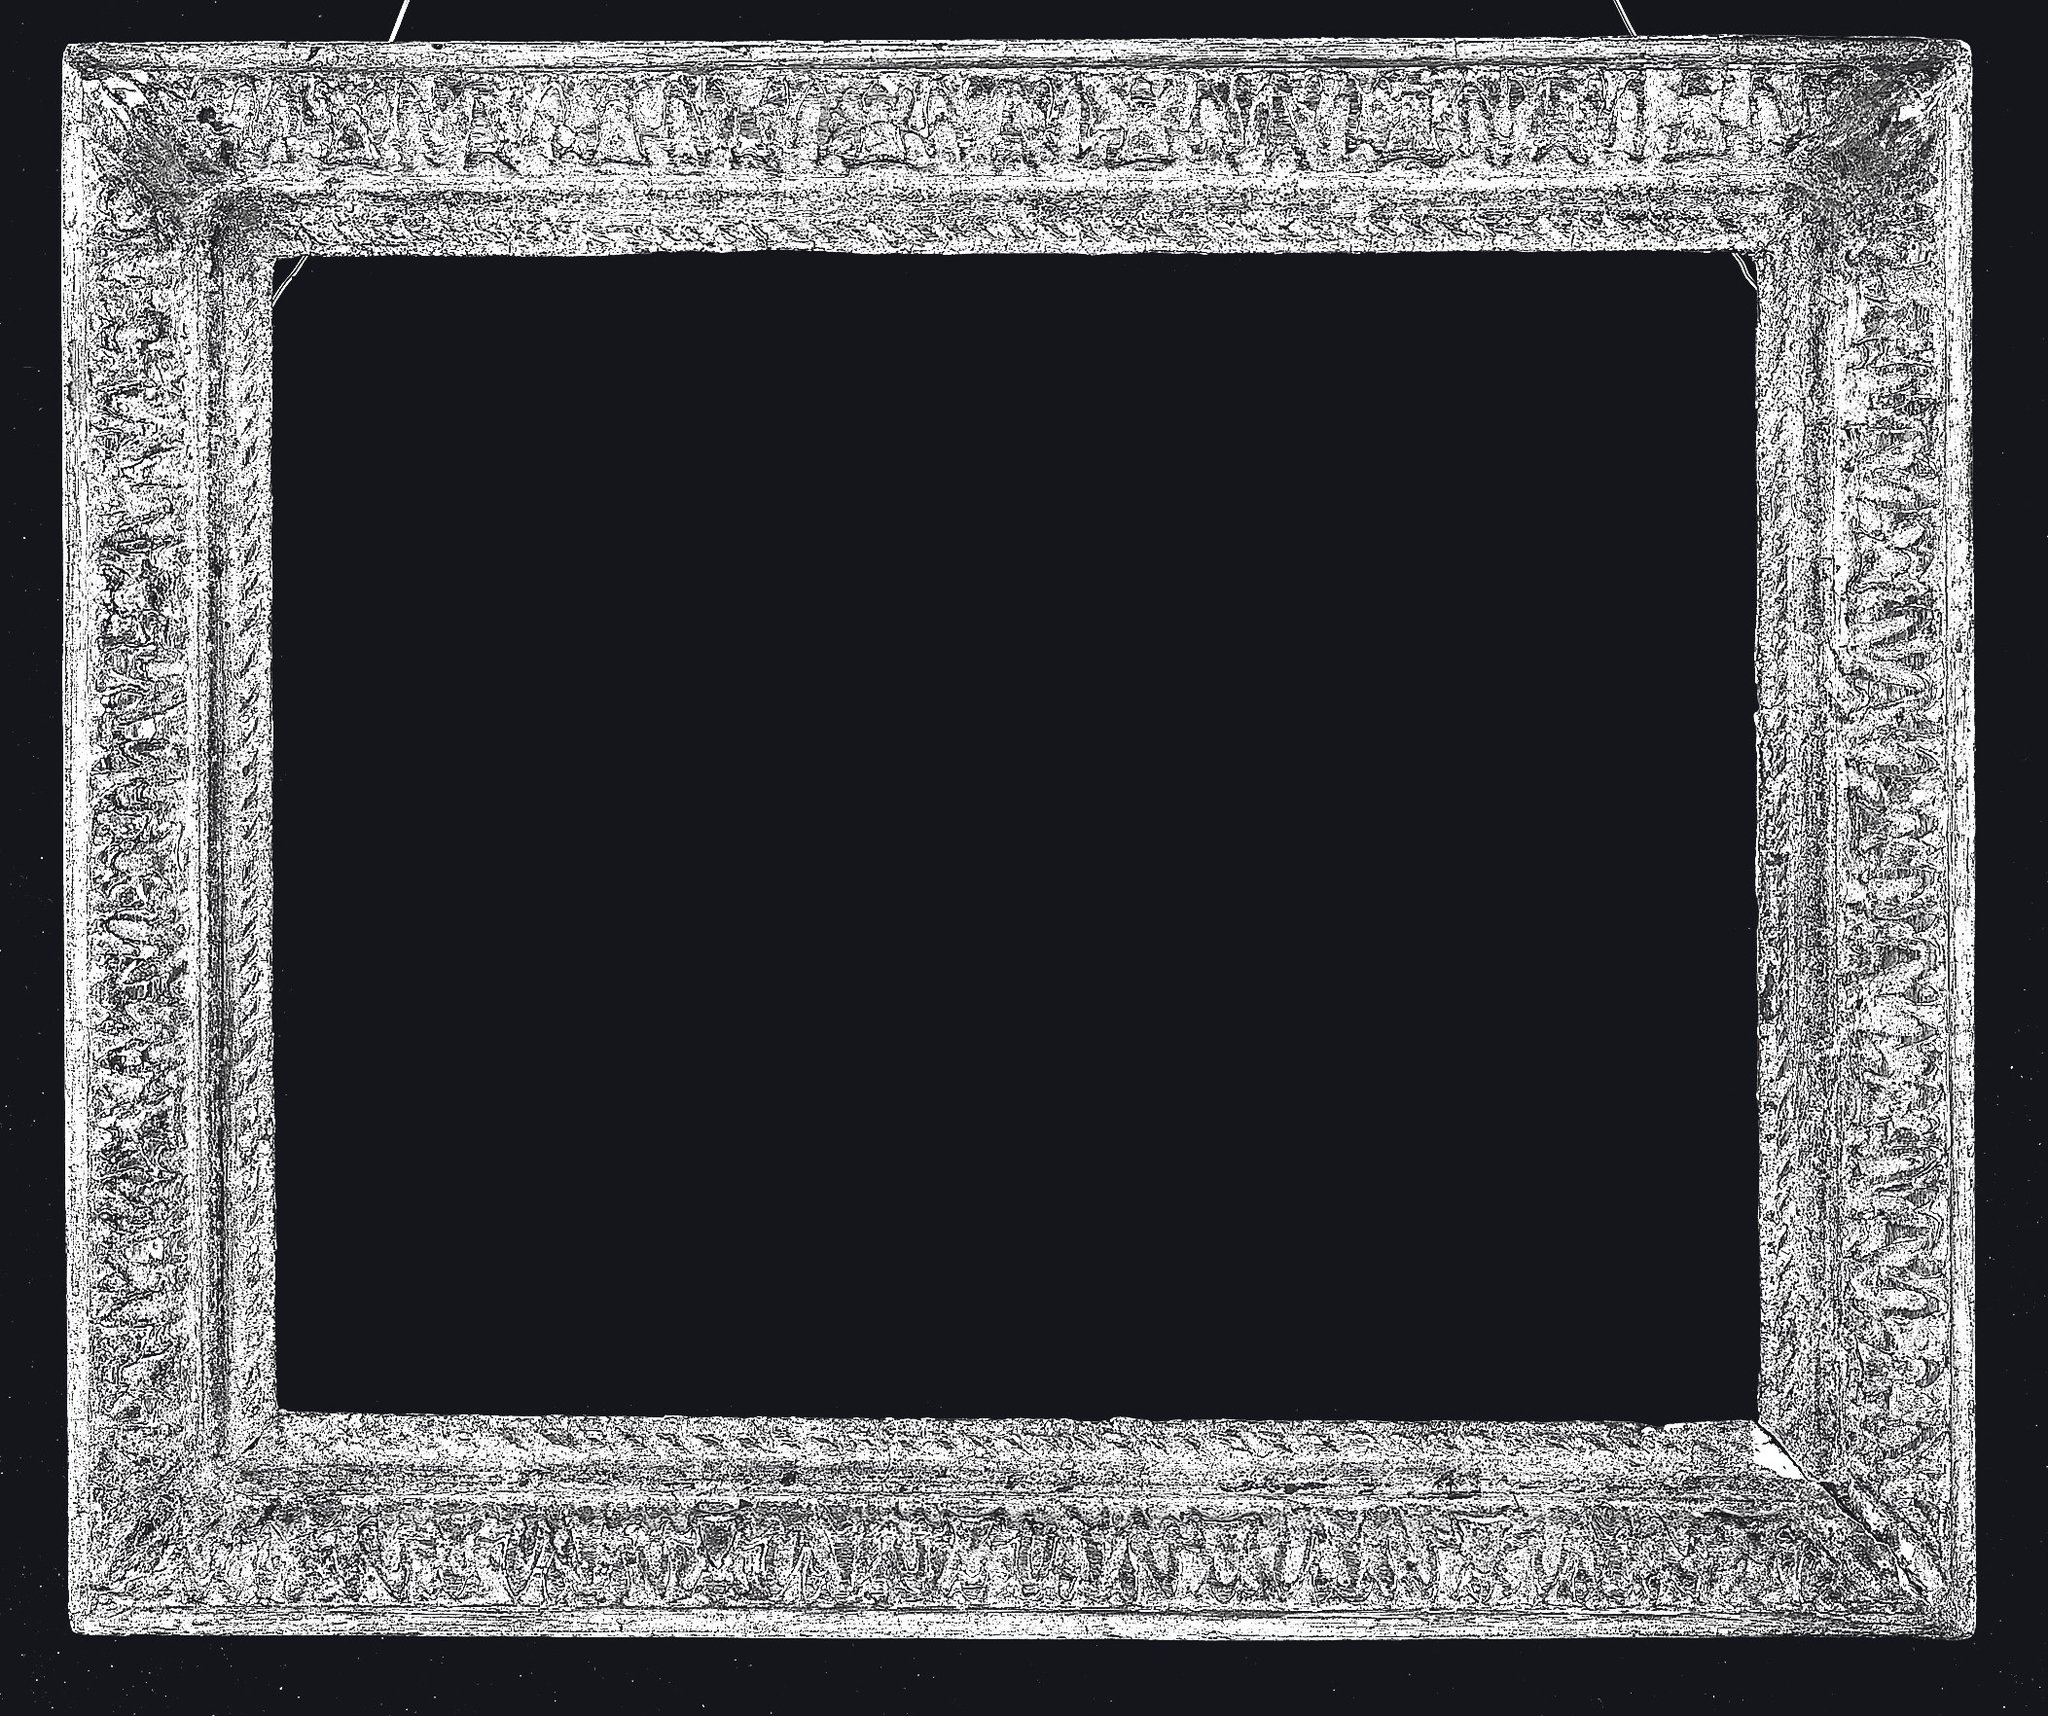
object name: frame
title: Ovolo frame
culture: french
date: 1650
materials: wood